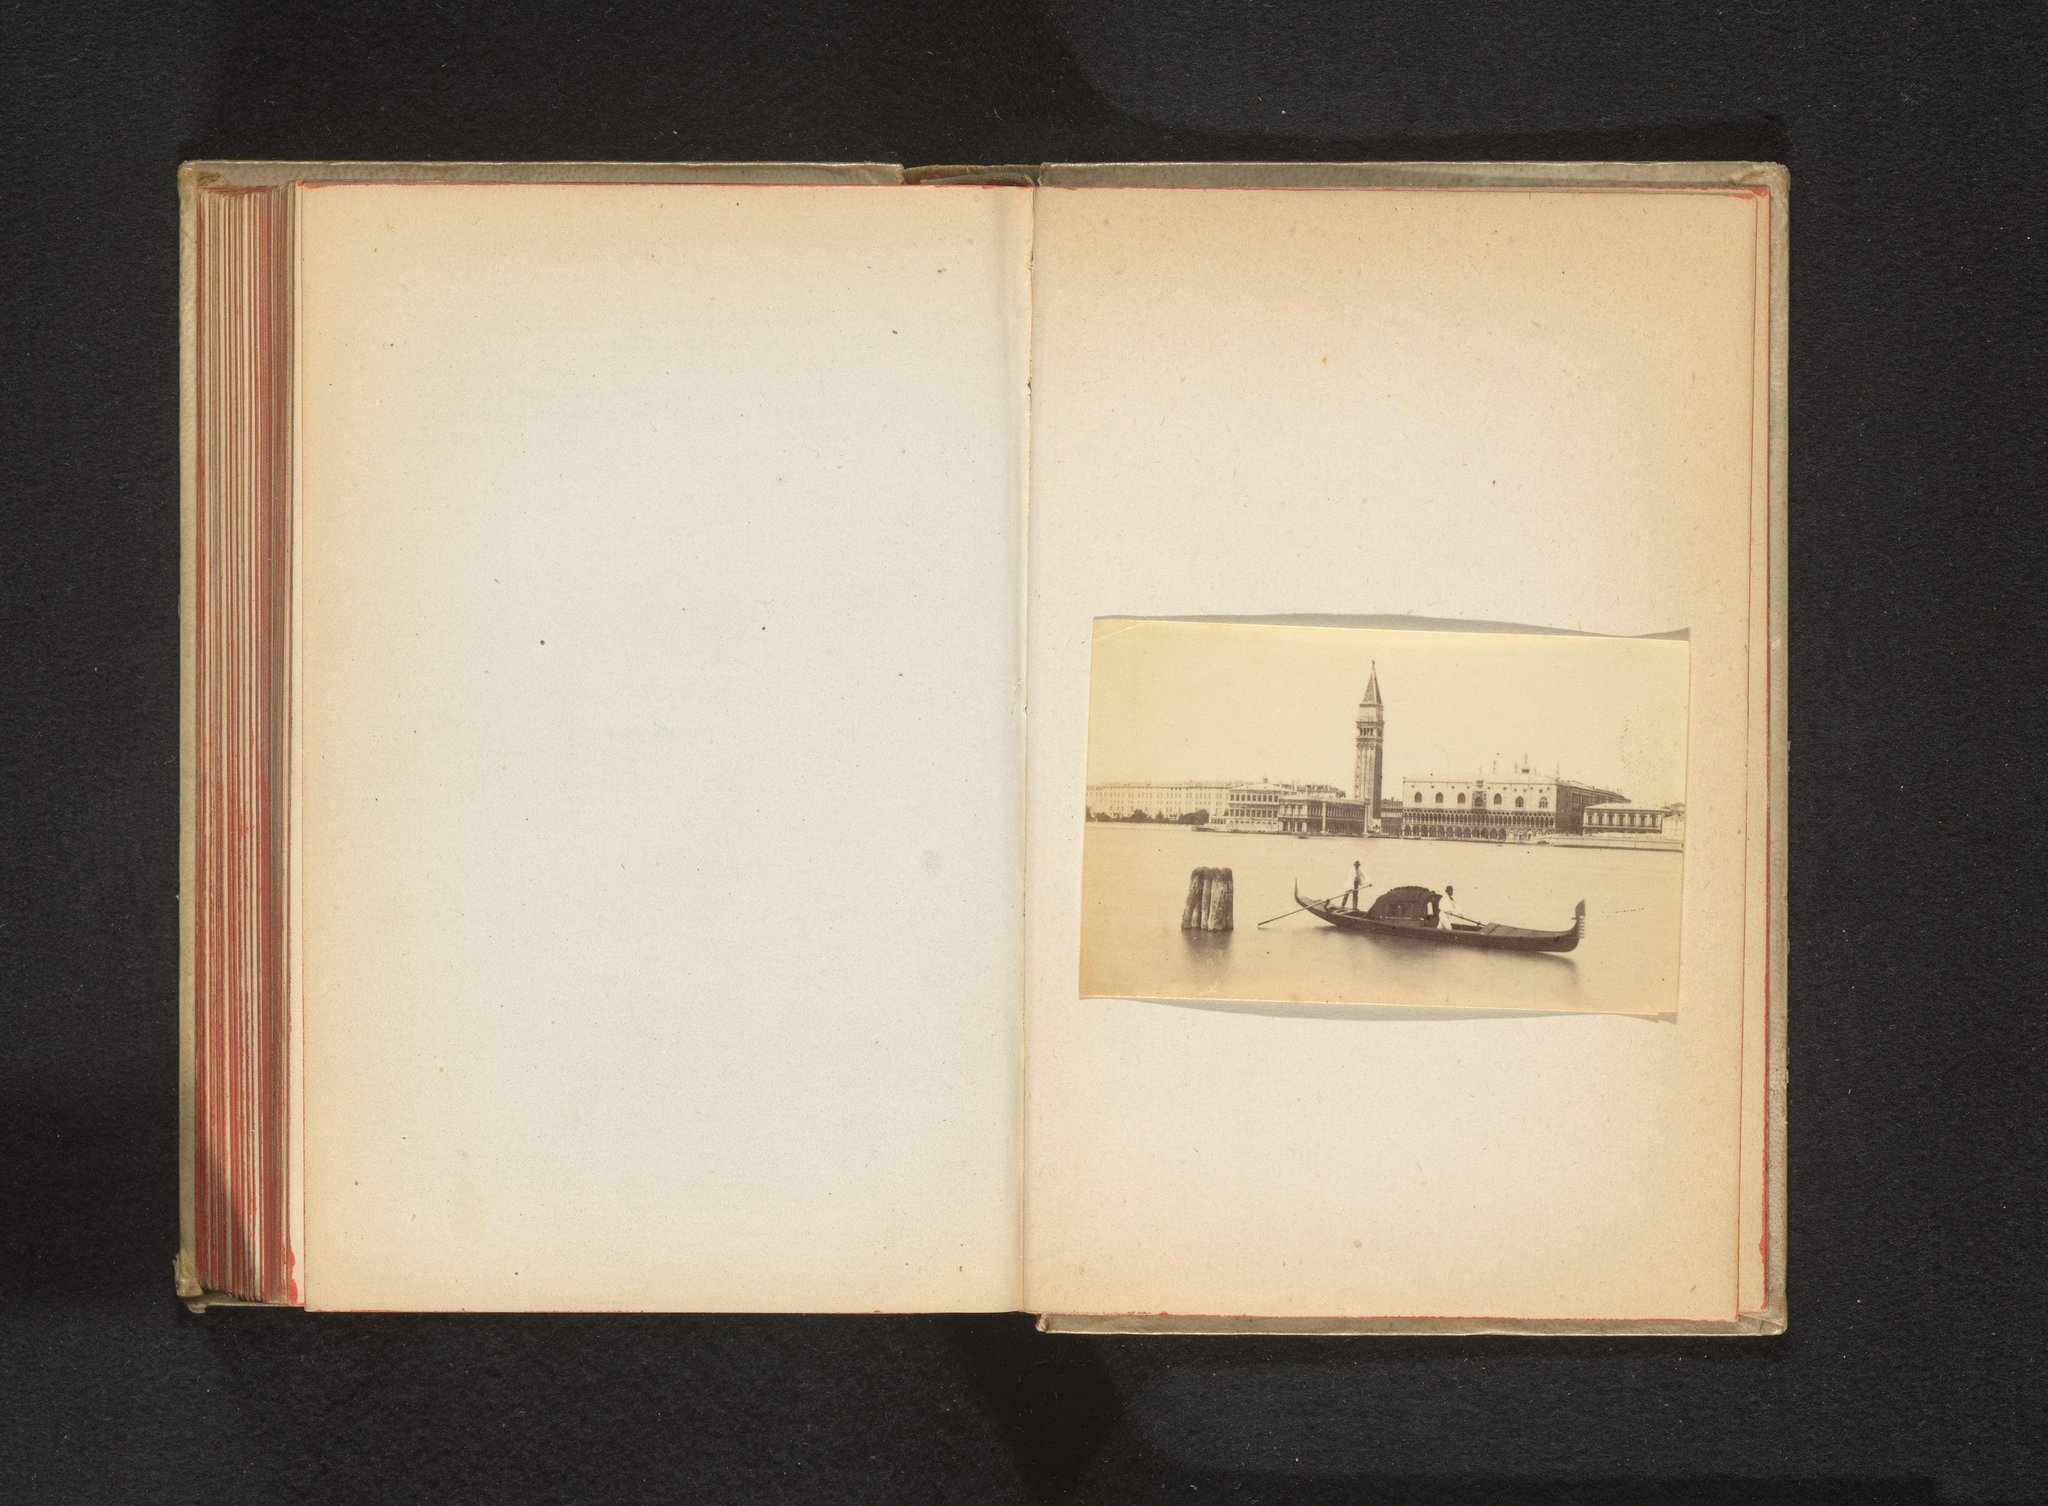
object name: page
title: Gezicht op Venetië vanaf het Isola di San Giorgio Maggiore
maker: Anonymous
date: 1863-1873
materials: photographic support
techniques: albumen print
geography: isola di san giorgio maggiore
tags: city-view in general; 'veduta', gondola, venice